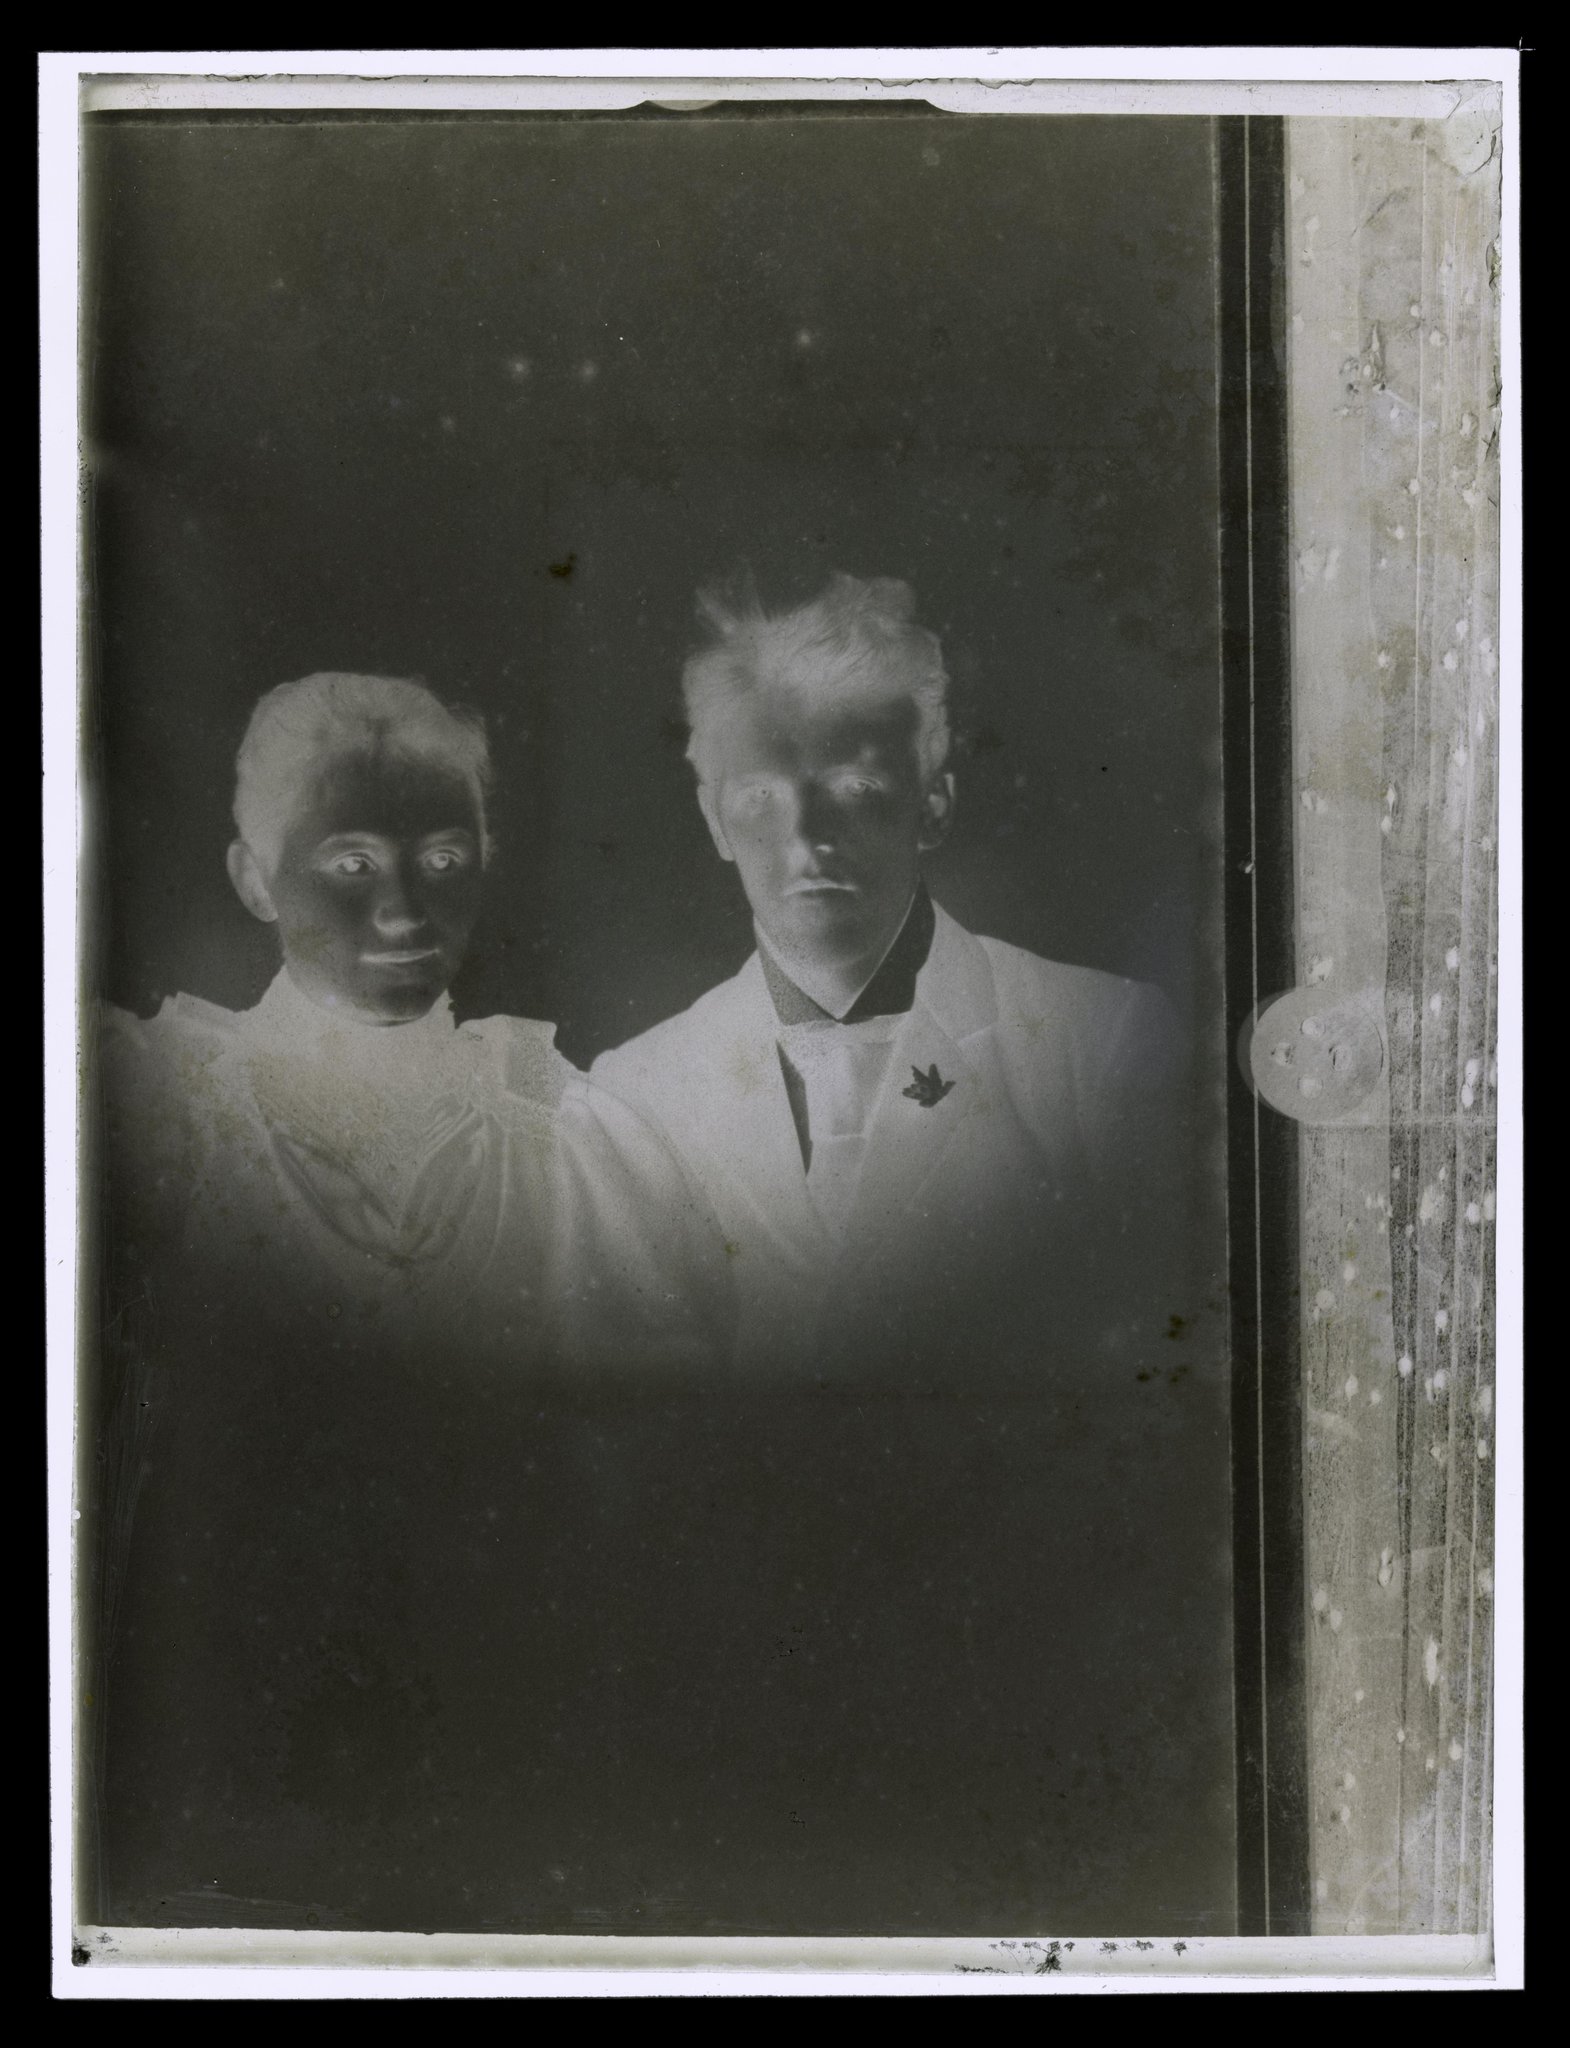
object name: glasnegatief, glasplaatnegatief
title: Portret van een onbekende vrouw, mogelijk Elsa Diepenbrock, en een onbekende man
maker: wouterus gijsbertus hondius van den broek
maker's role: amateurfotograaf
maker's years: 1867-1913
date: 1895-1925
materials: glass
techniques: gelatin glass negative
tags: anonymous historical persons portrayed in a double portrait